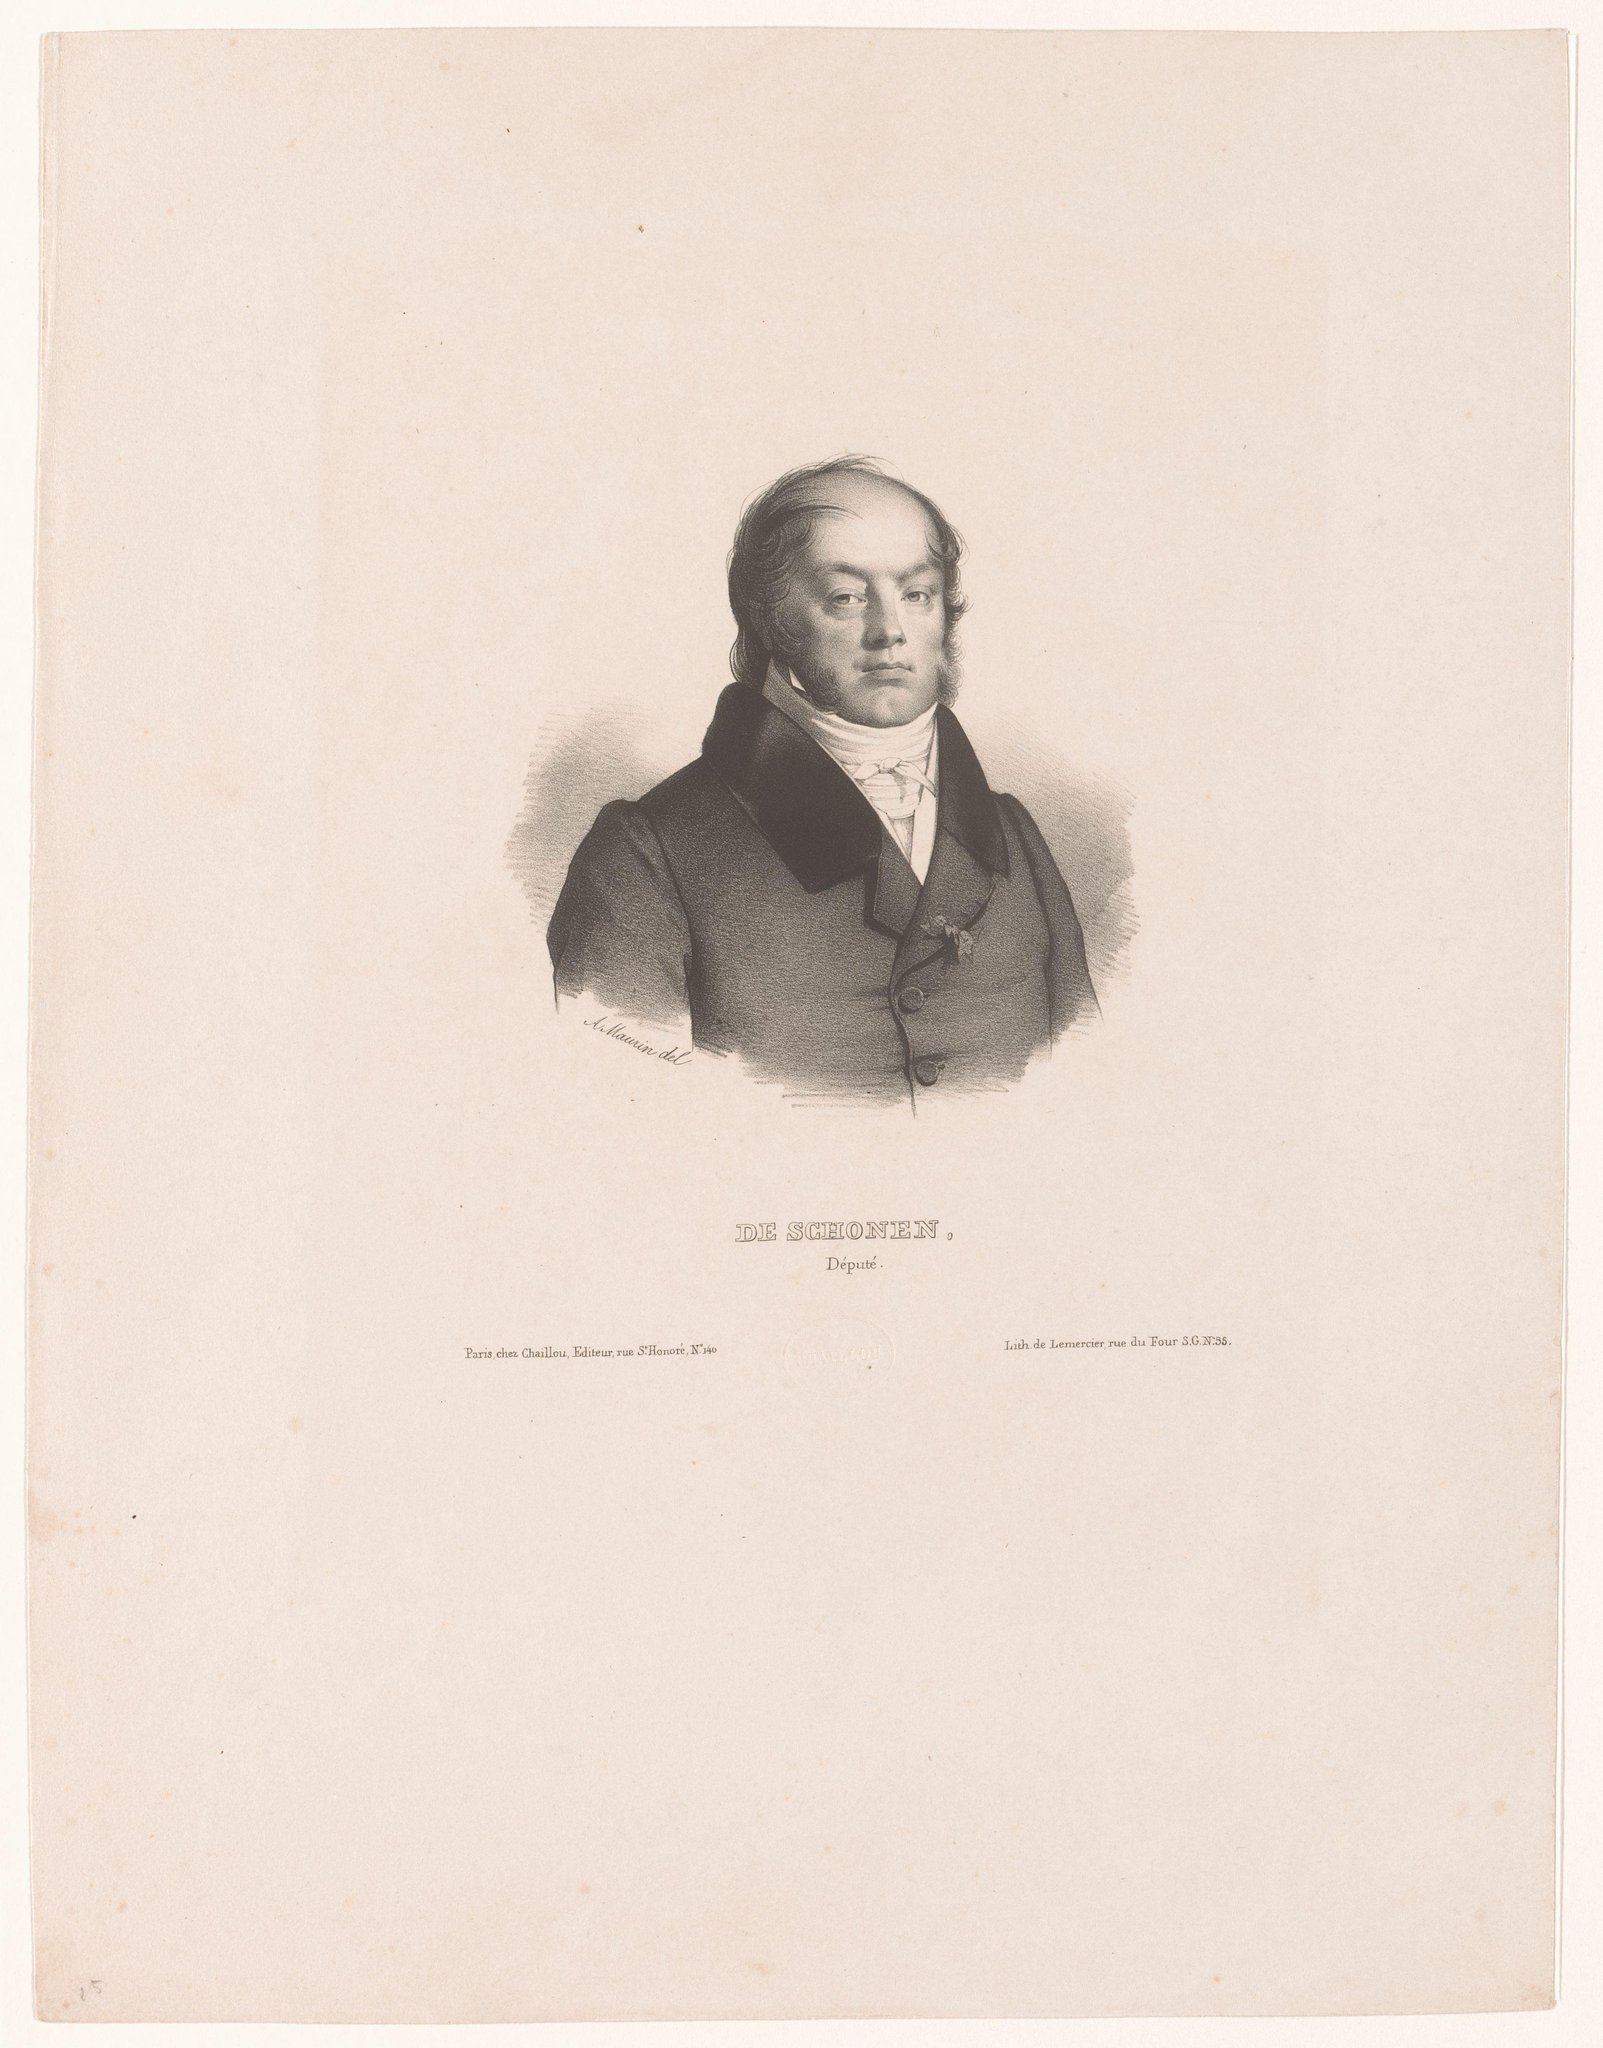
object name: print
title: De Schonen, député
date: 1828-1838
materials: paper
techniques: lithograph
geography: paris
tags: historical persons, politician, e.g. party leader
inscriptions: collector's mark: Lugt 2228, check stamp: Lugt 4733